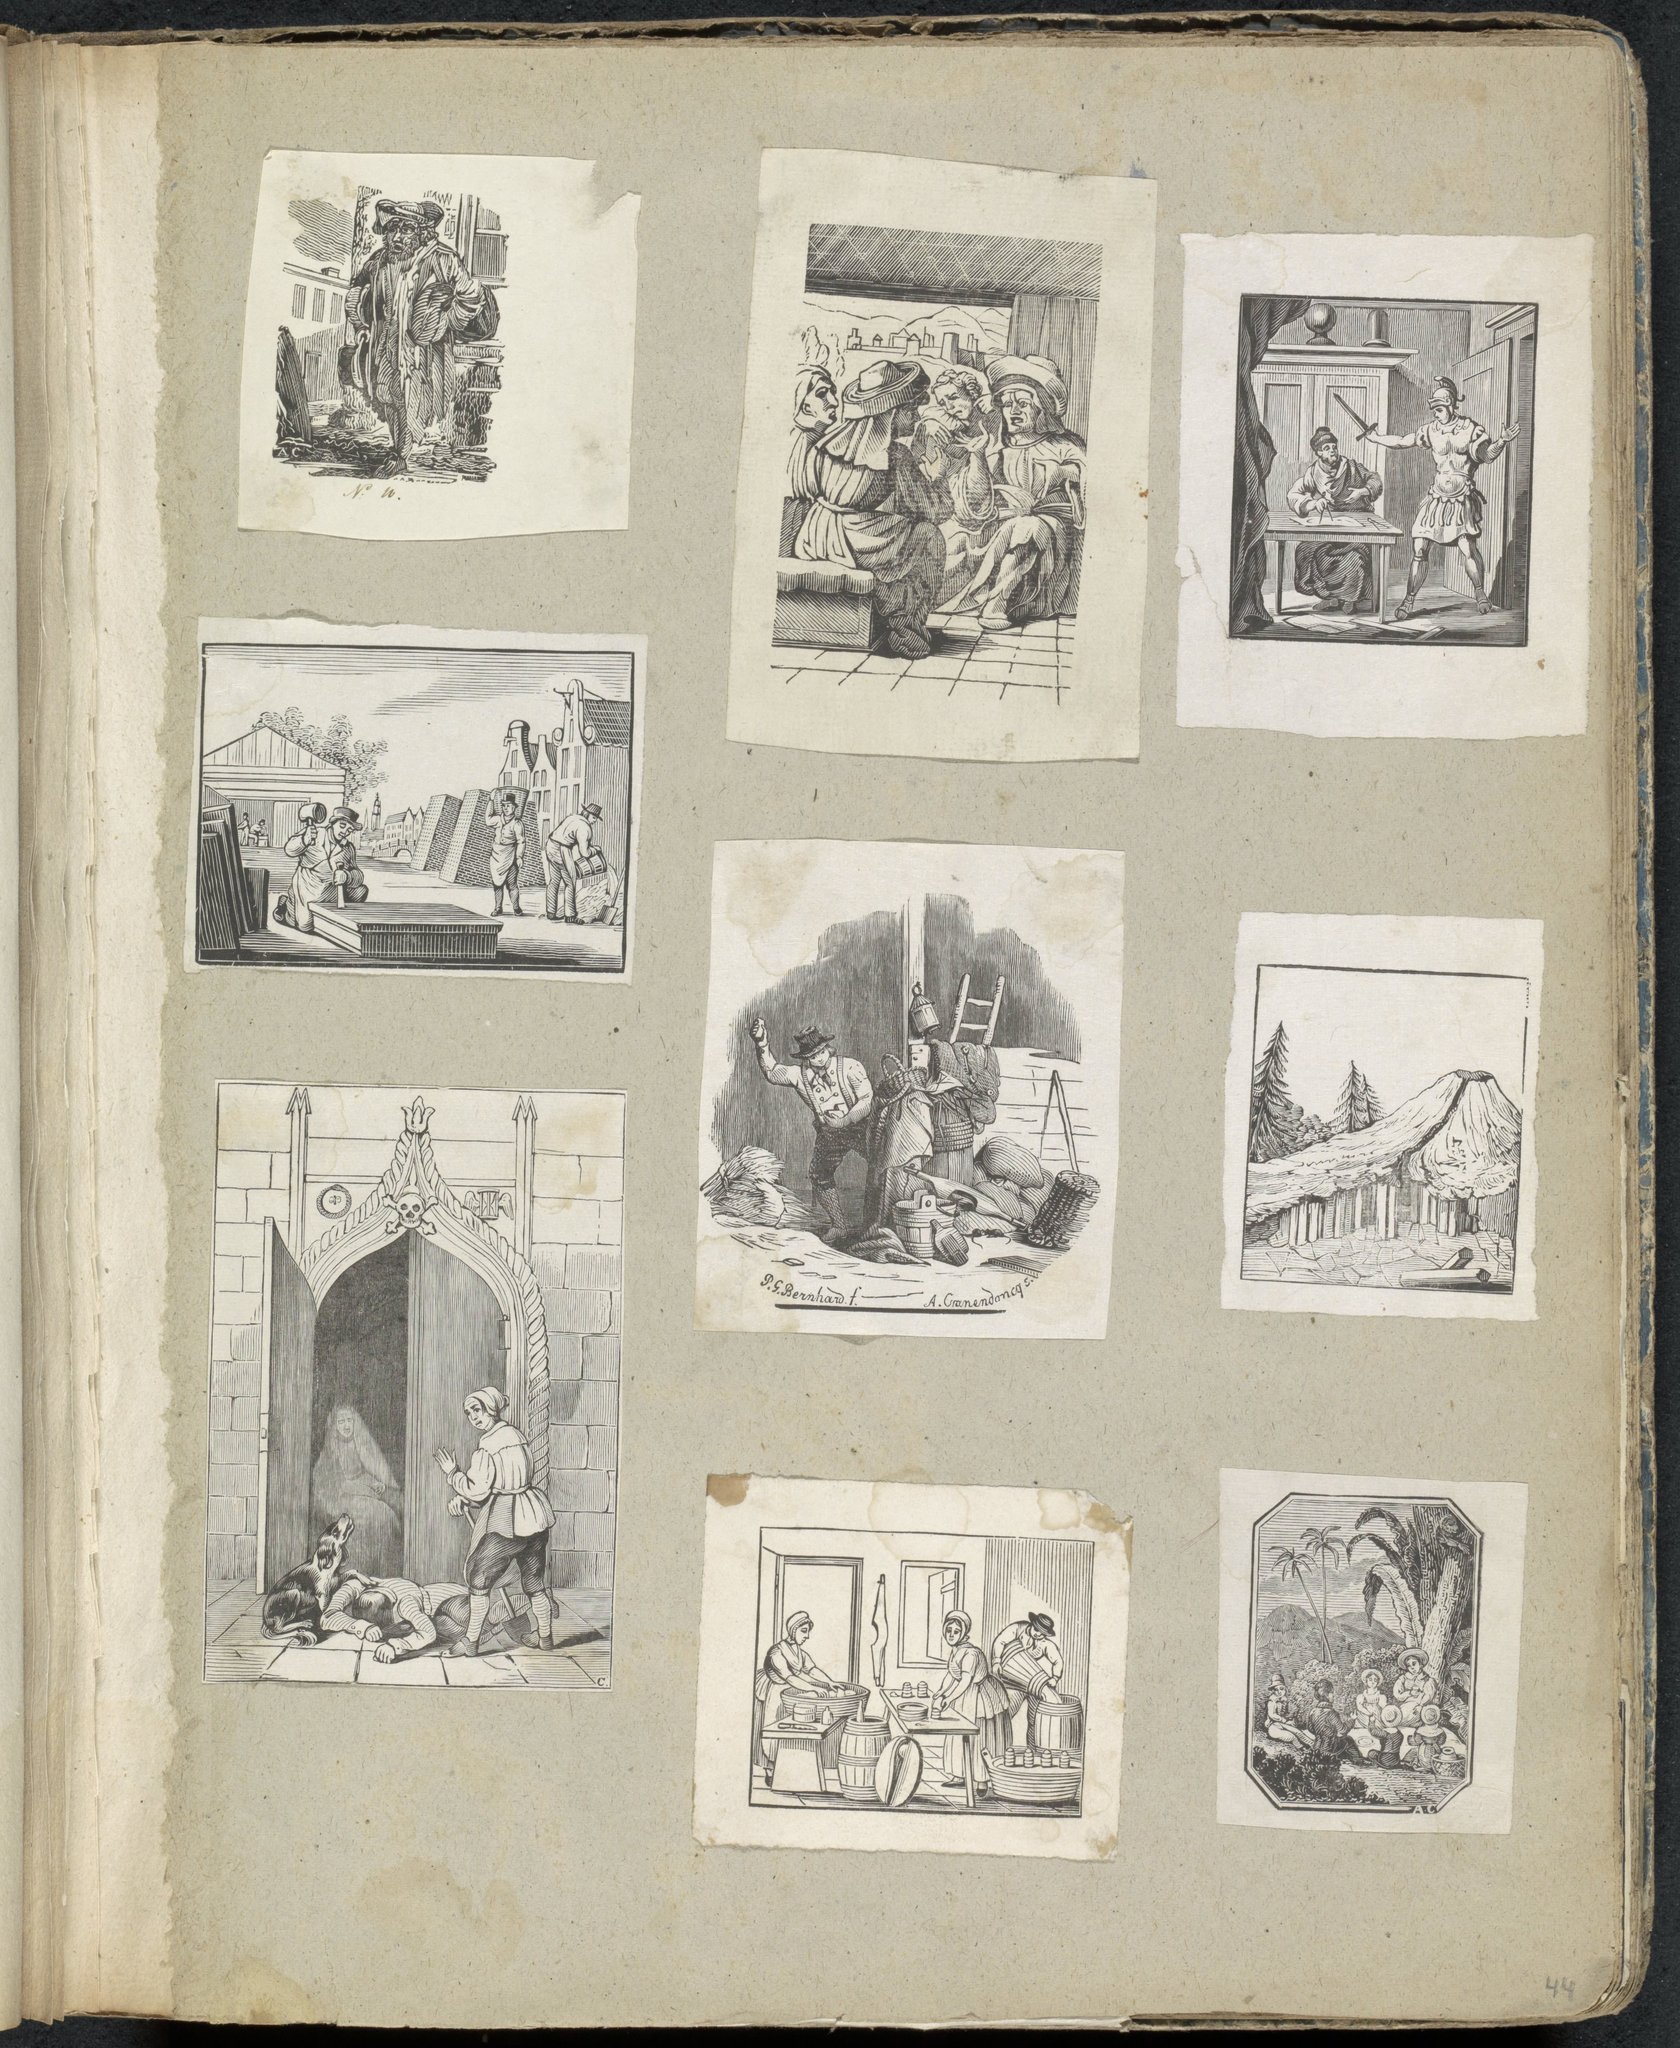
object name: print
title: Albumblad met diverse voorstellingen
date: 1814-1869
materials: paper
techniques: snipping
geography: netherlands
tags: stone-cutter, stone-sawyer, human types, picnic, alfresco, 'déjeuner sur l'herbe', volcano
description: Albumblad met 9 uitgeknipte voorstellingen uit voornamelijk volksprenten, onder andere van een steenhouwer, een boer die muizen probeert te vangen, een vulkaan en een picknickende familie.